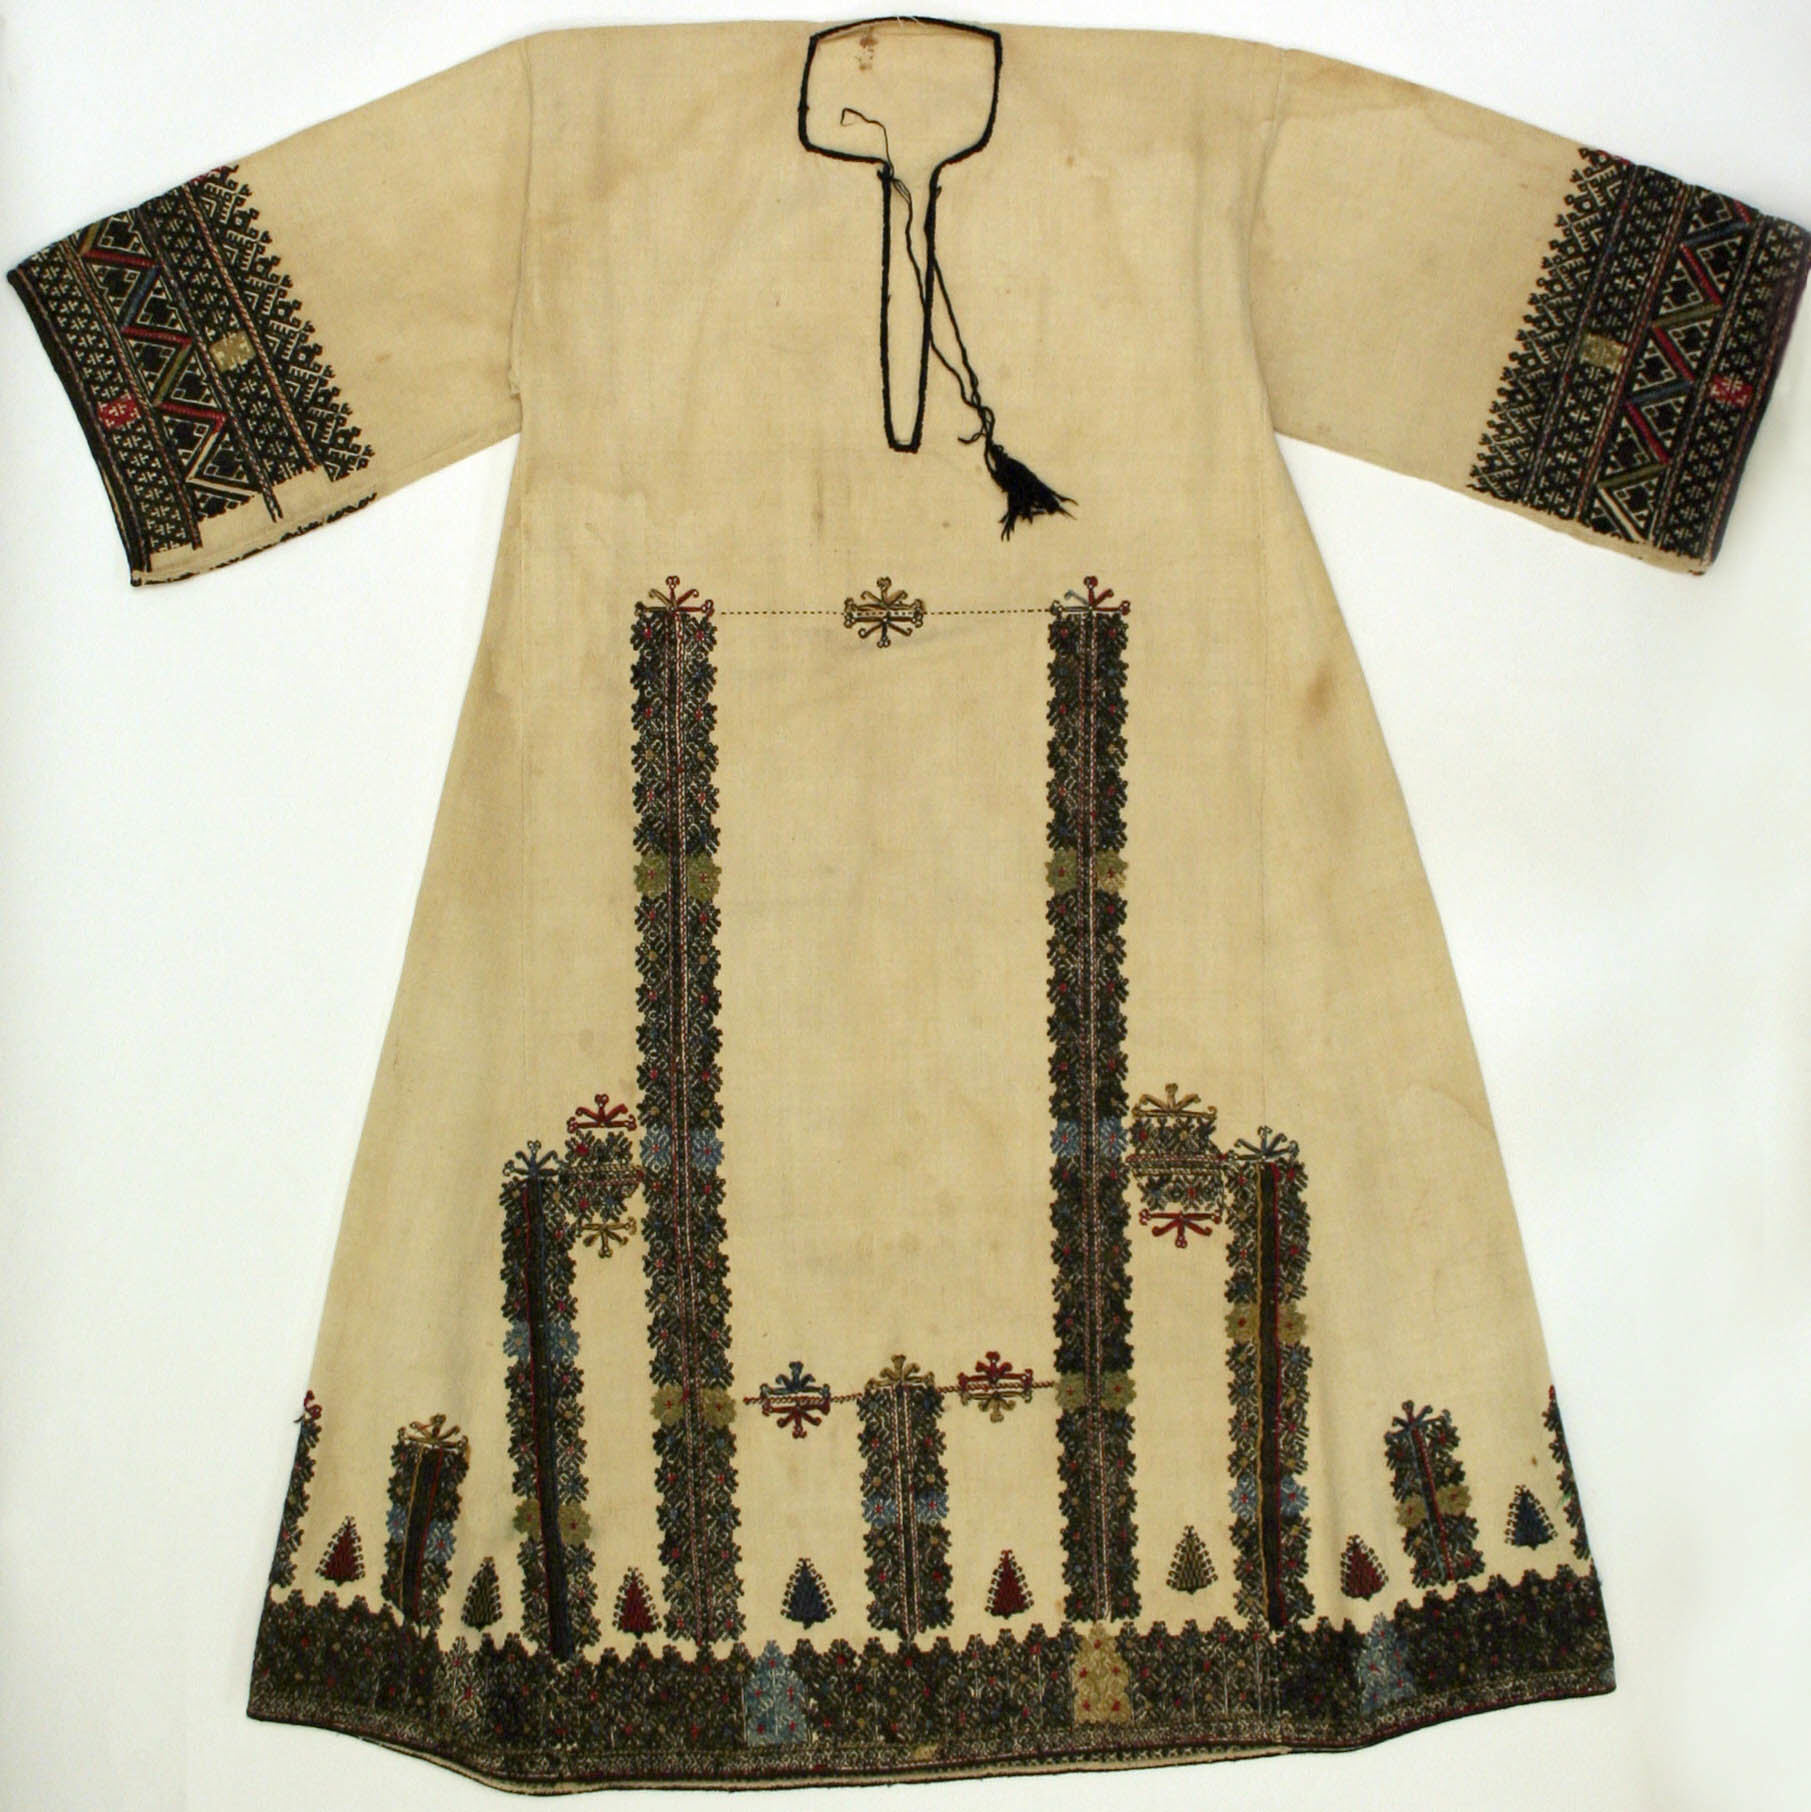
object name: ensemble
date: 1801-1933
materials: cotton, leather, metal, silk, wool